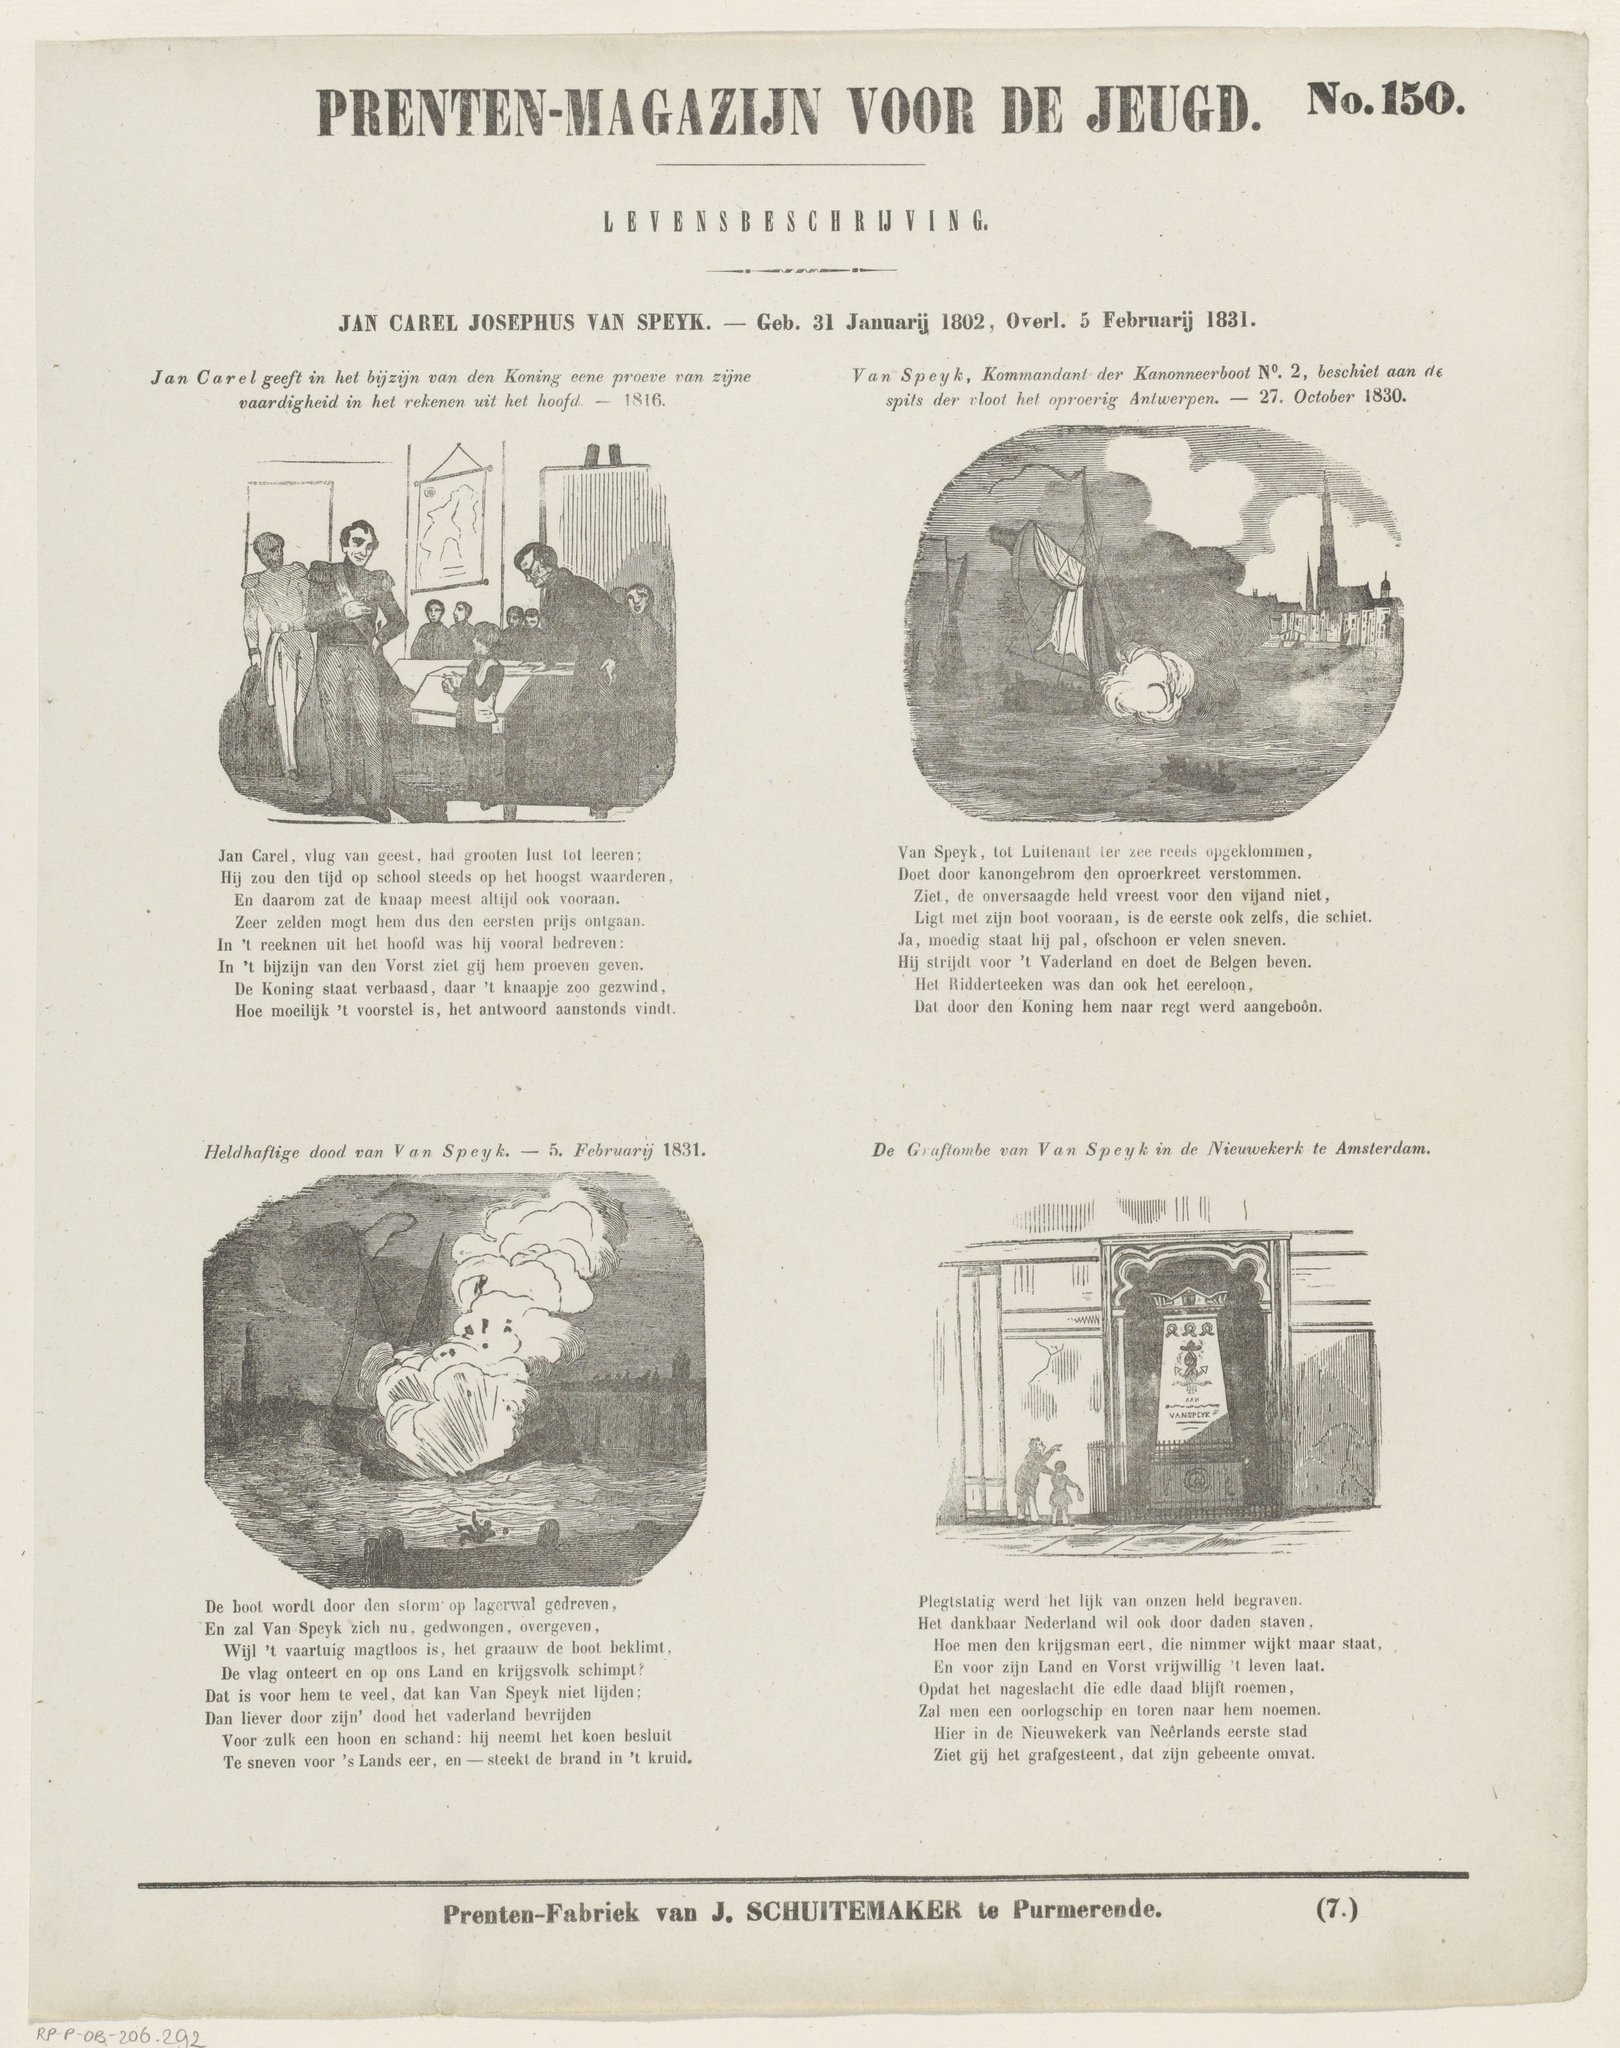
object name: print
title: Prenten-magazijn voor de jeugd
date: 1850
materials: paper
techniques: letterpress printing, engraving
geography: purmerend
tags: antwerp, jan van speyk, historical persons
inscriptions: collector's mark: Lugt 2760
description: Na voltooiing van de acht jaargangen van de reeks 'Prenten-magazijn voor de jeugd' in 1850 heeft Jan Schuitemaker al deze prenten heruitgegeven en omgenummerd als nr. 1 t/m 192. De oorspronkelijke jaargang wordt telkens nog vermeld rechtsonder op de prent. Binnen de jaargangen zijn prenten van hetzelfde thema in clusters van vier achter elkaar gezet.